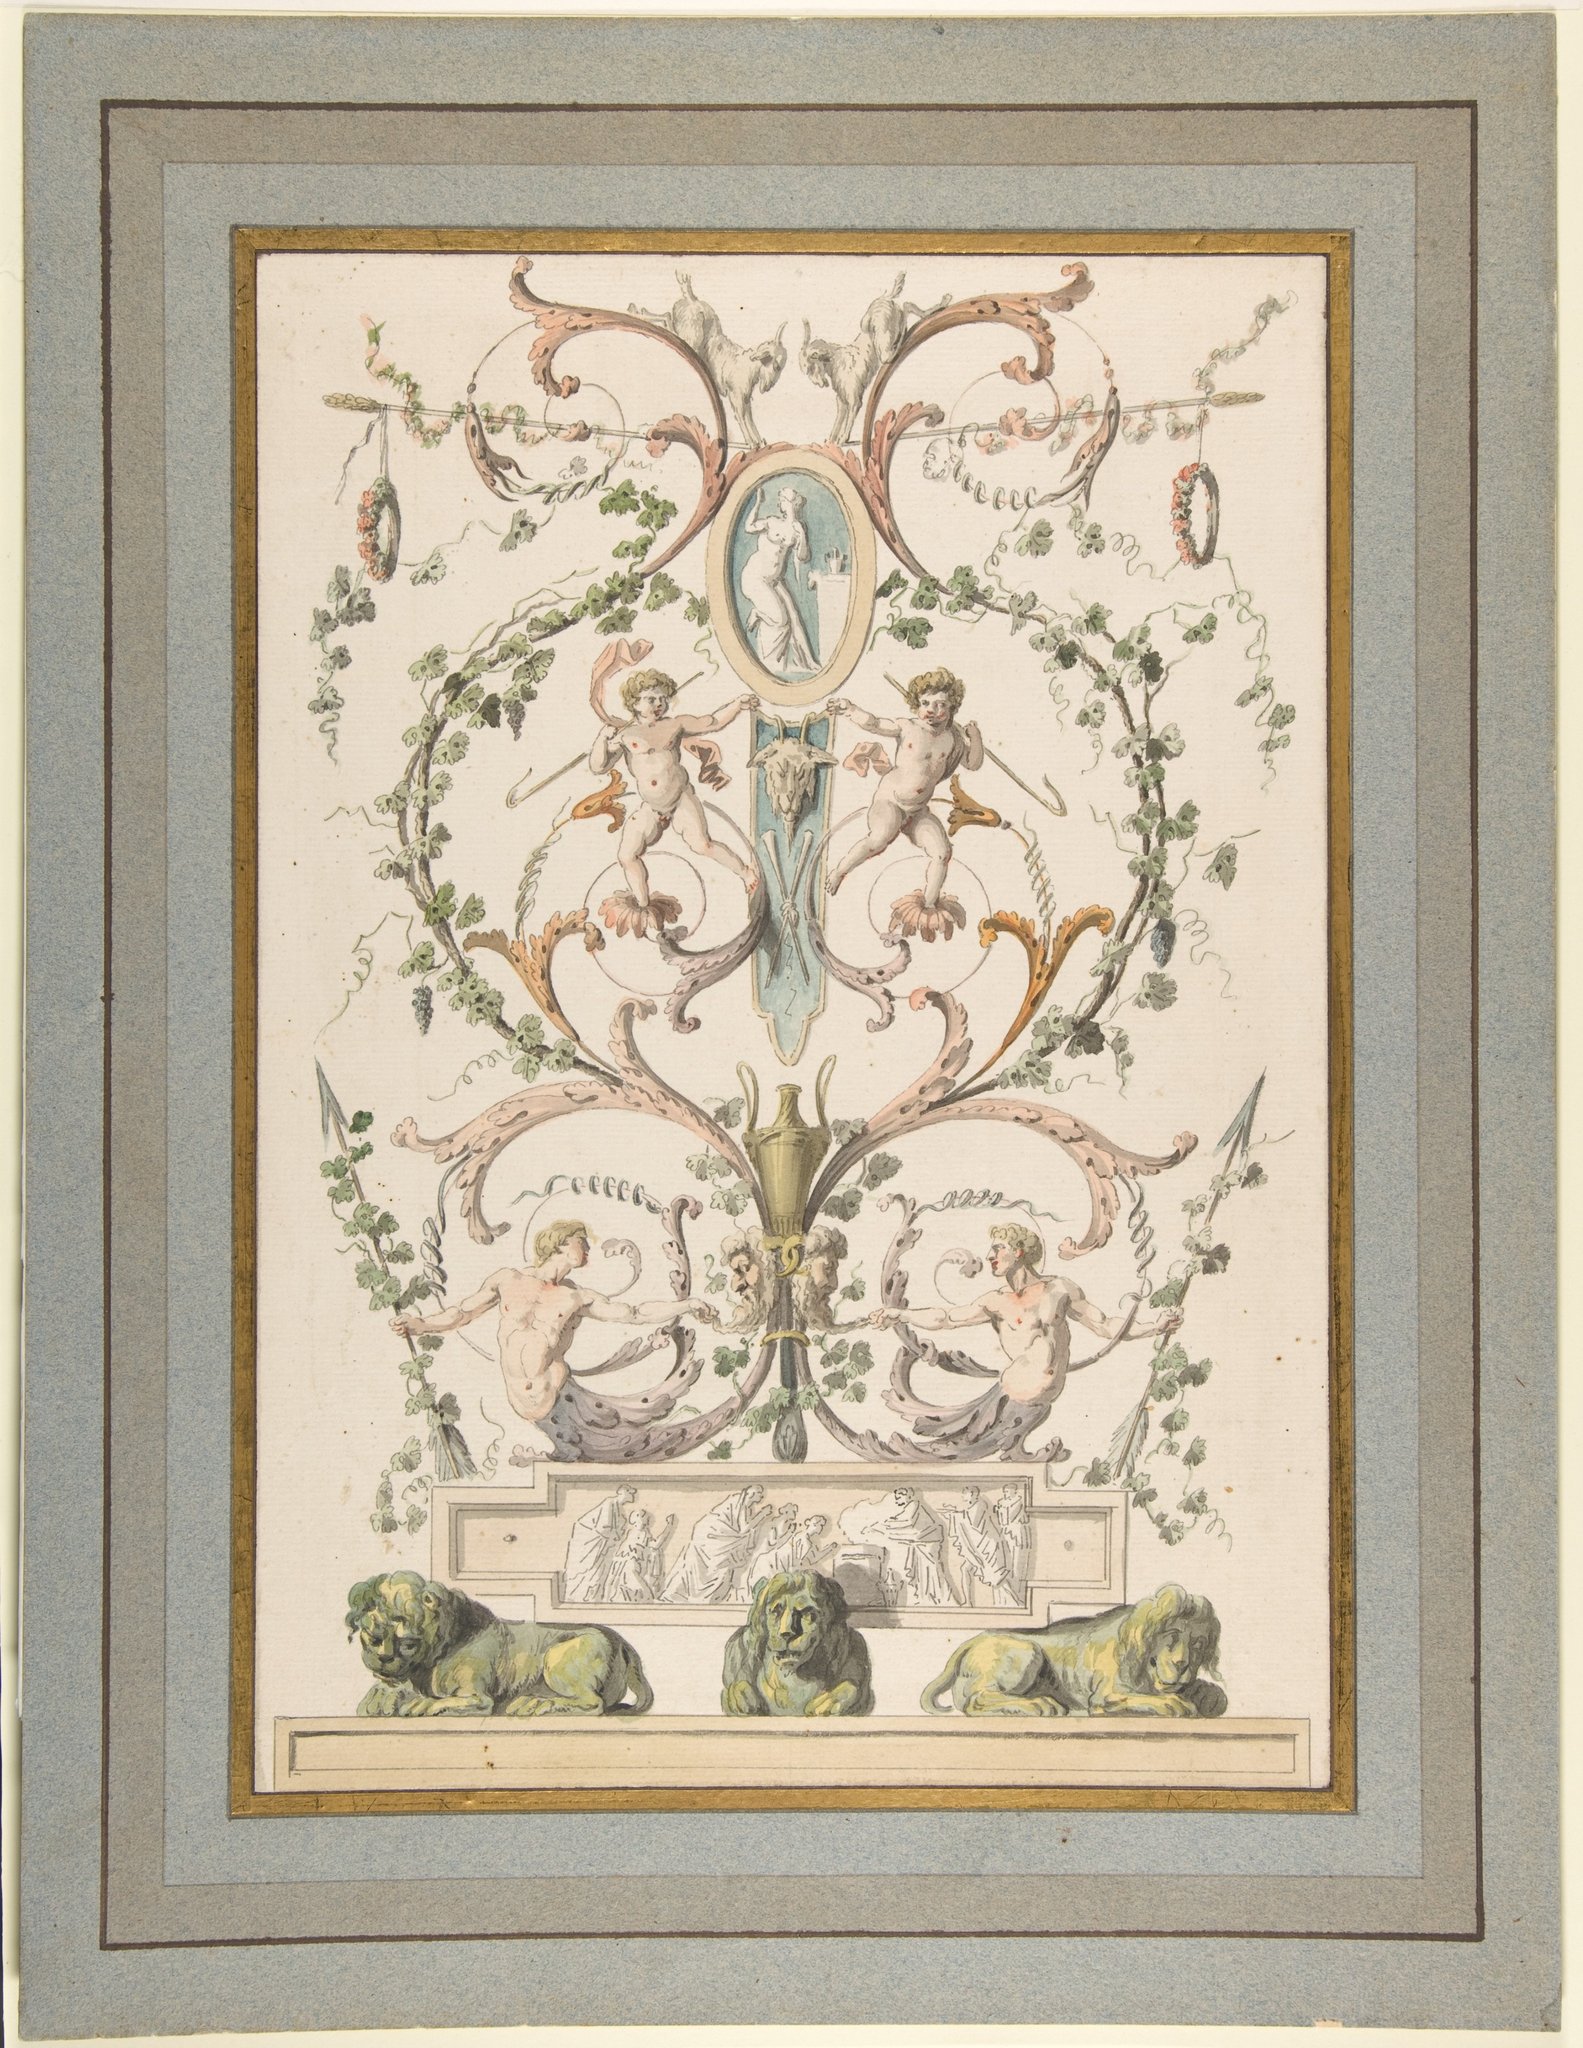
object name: drawing collection ornament architecture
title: Design for an Arabesque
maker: etienne de lavallée-poussin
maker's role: artist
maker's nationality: french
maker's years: 1733-1793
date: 1780-1793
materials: ink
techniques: brush, pen, wash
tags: women,lions